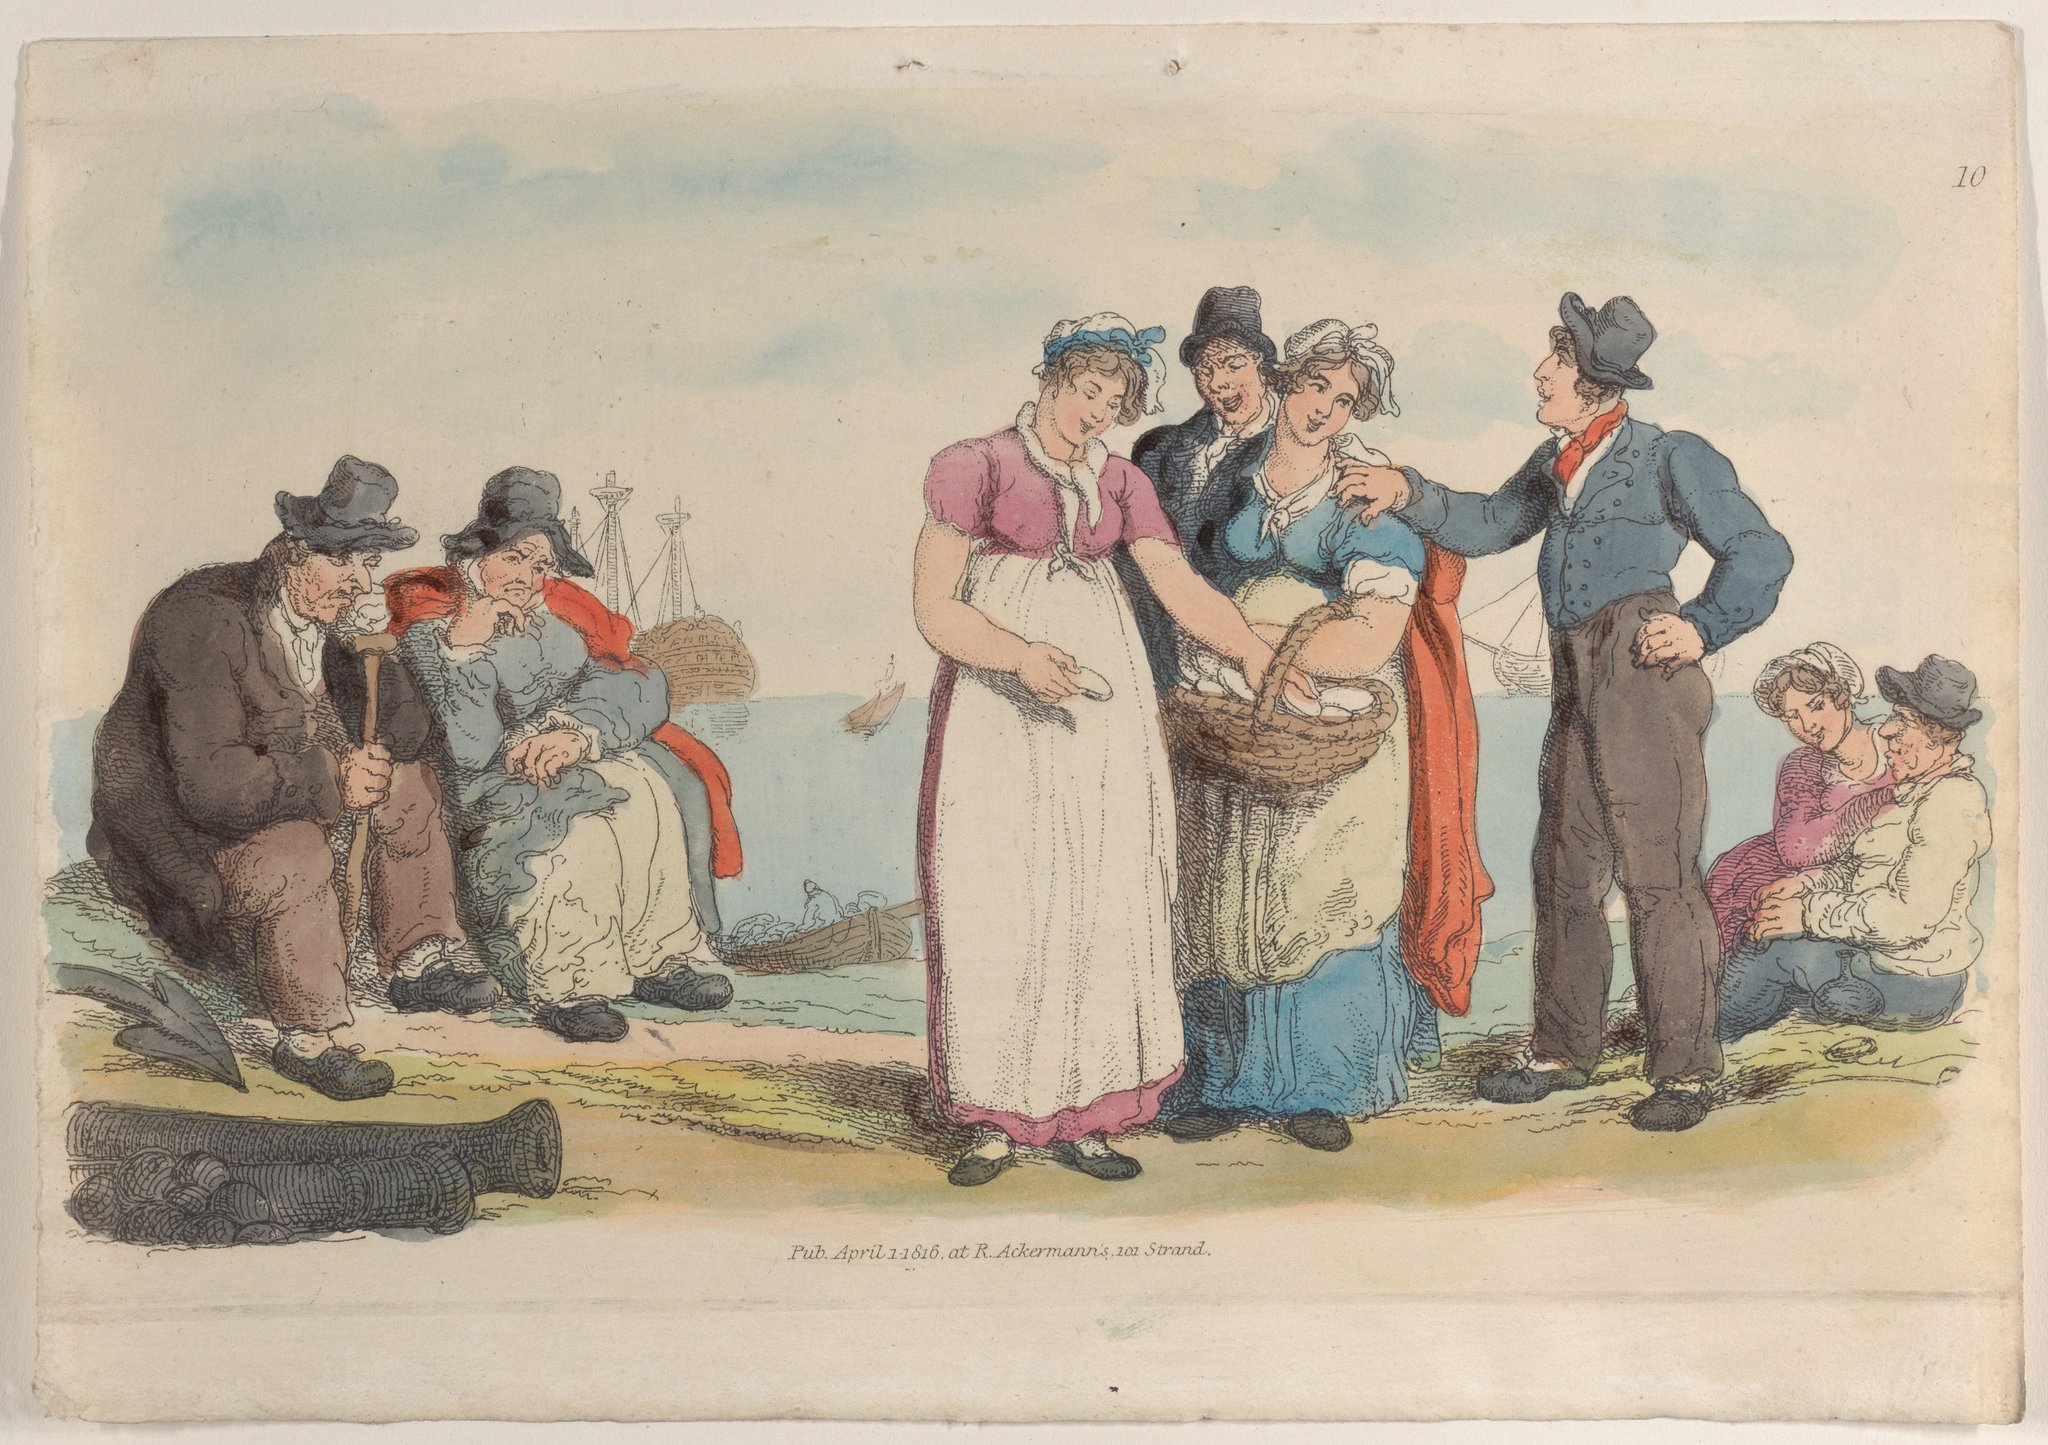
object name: print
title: Plate 10, from "World in Miniature"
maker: thomas rowlandson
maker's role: artist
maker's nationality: british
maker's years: 1757-1827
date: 1816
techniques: etching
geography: london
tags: men,women,oysters